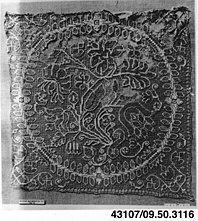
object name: square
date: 1601-1700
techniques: embroidery